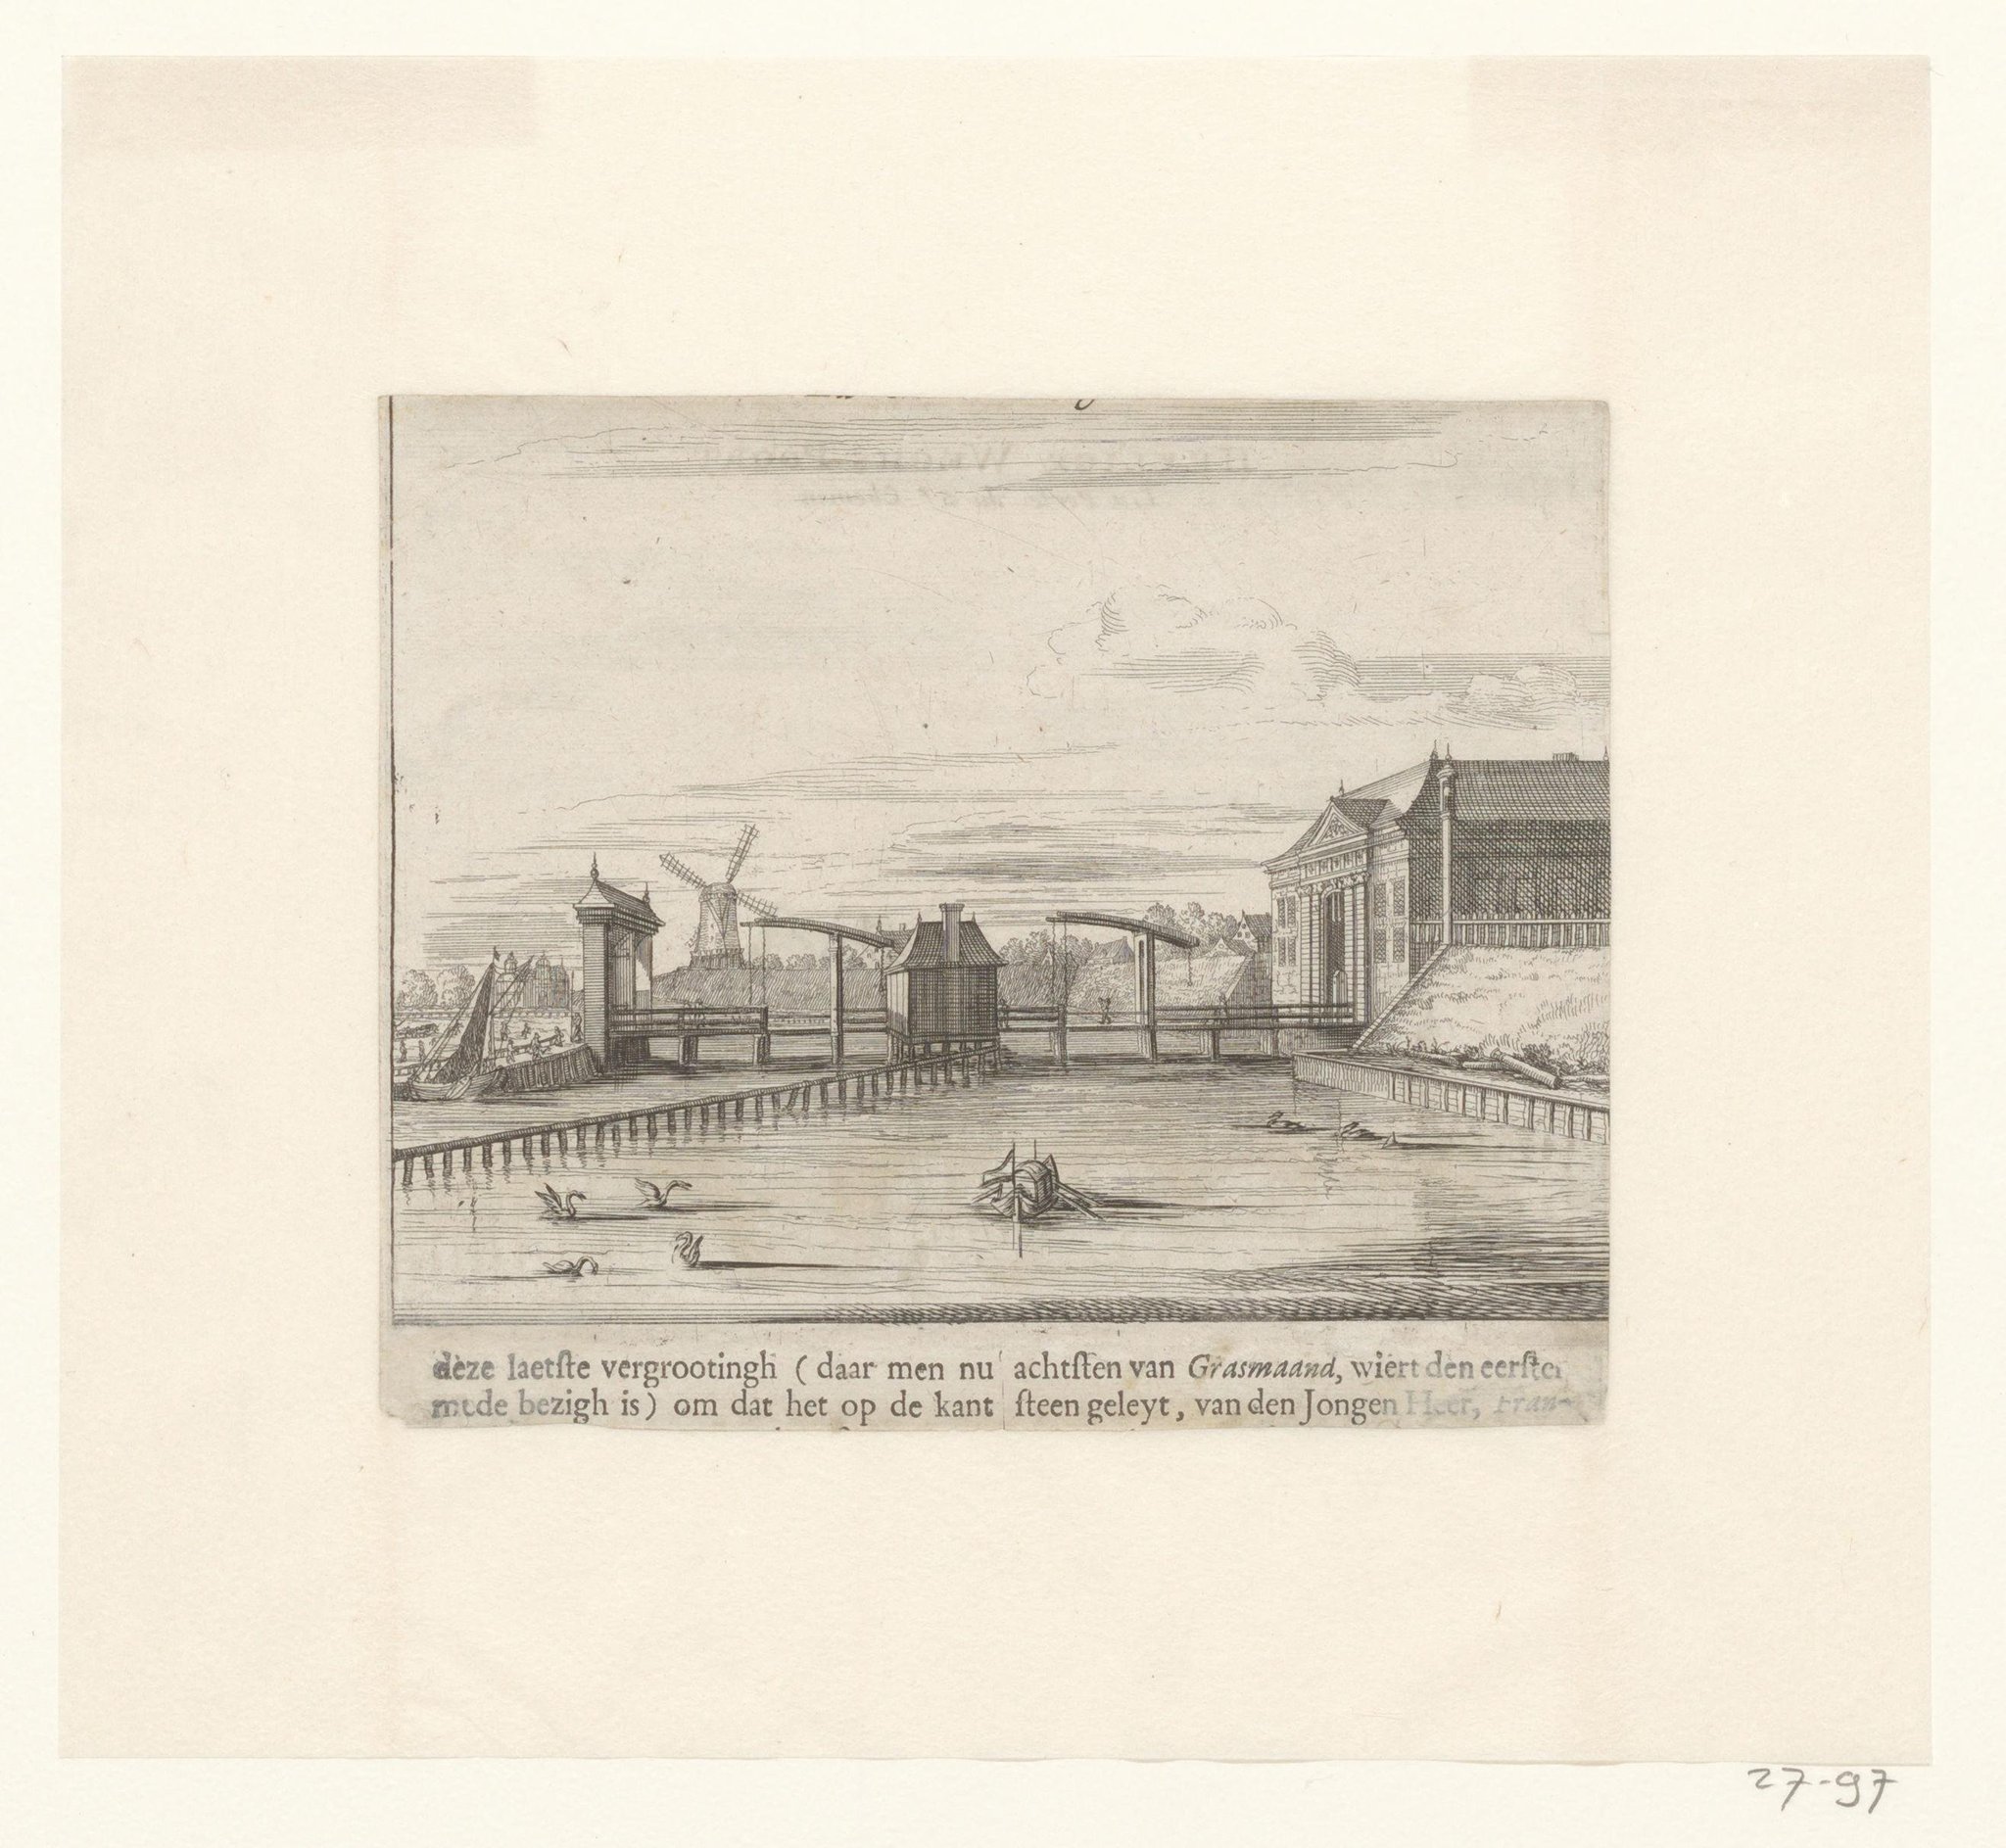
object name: print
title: Gezicht op de Haarlemmerpoort te Amsterdam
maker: Anonymous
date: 1650-1749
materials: paper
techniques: etching, letterpress printing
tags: rowing-boat, canoe, etc., bridge in city across river, canal, etc.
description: Prent uit: Beschryvinge van Amsterdam, haar eerste oorspronk uyt den huyze der heeren van Aemstel en Aemstellant (...). Amsterdam: Marcus Willemsz. Doornick, 1665.